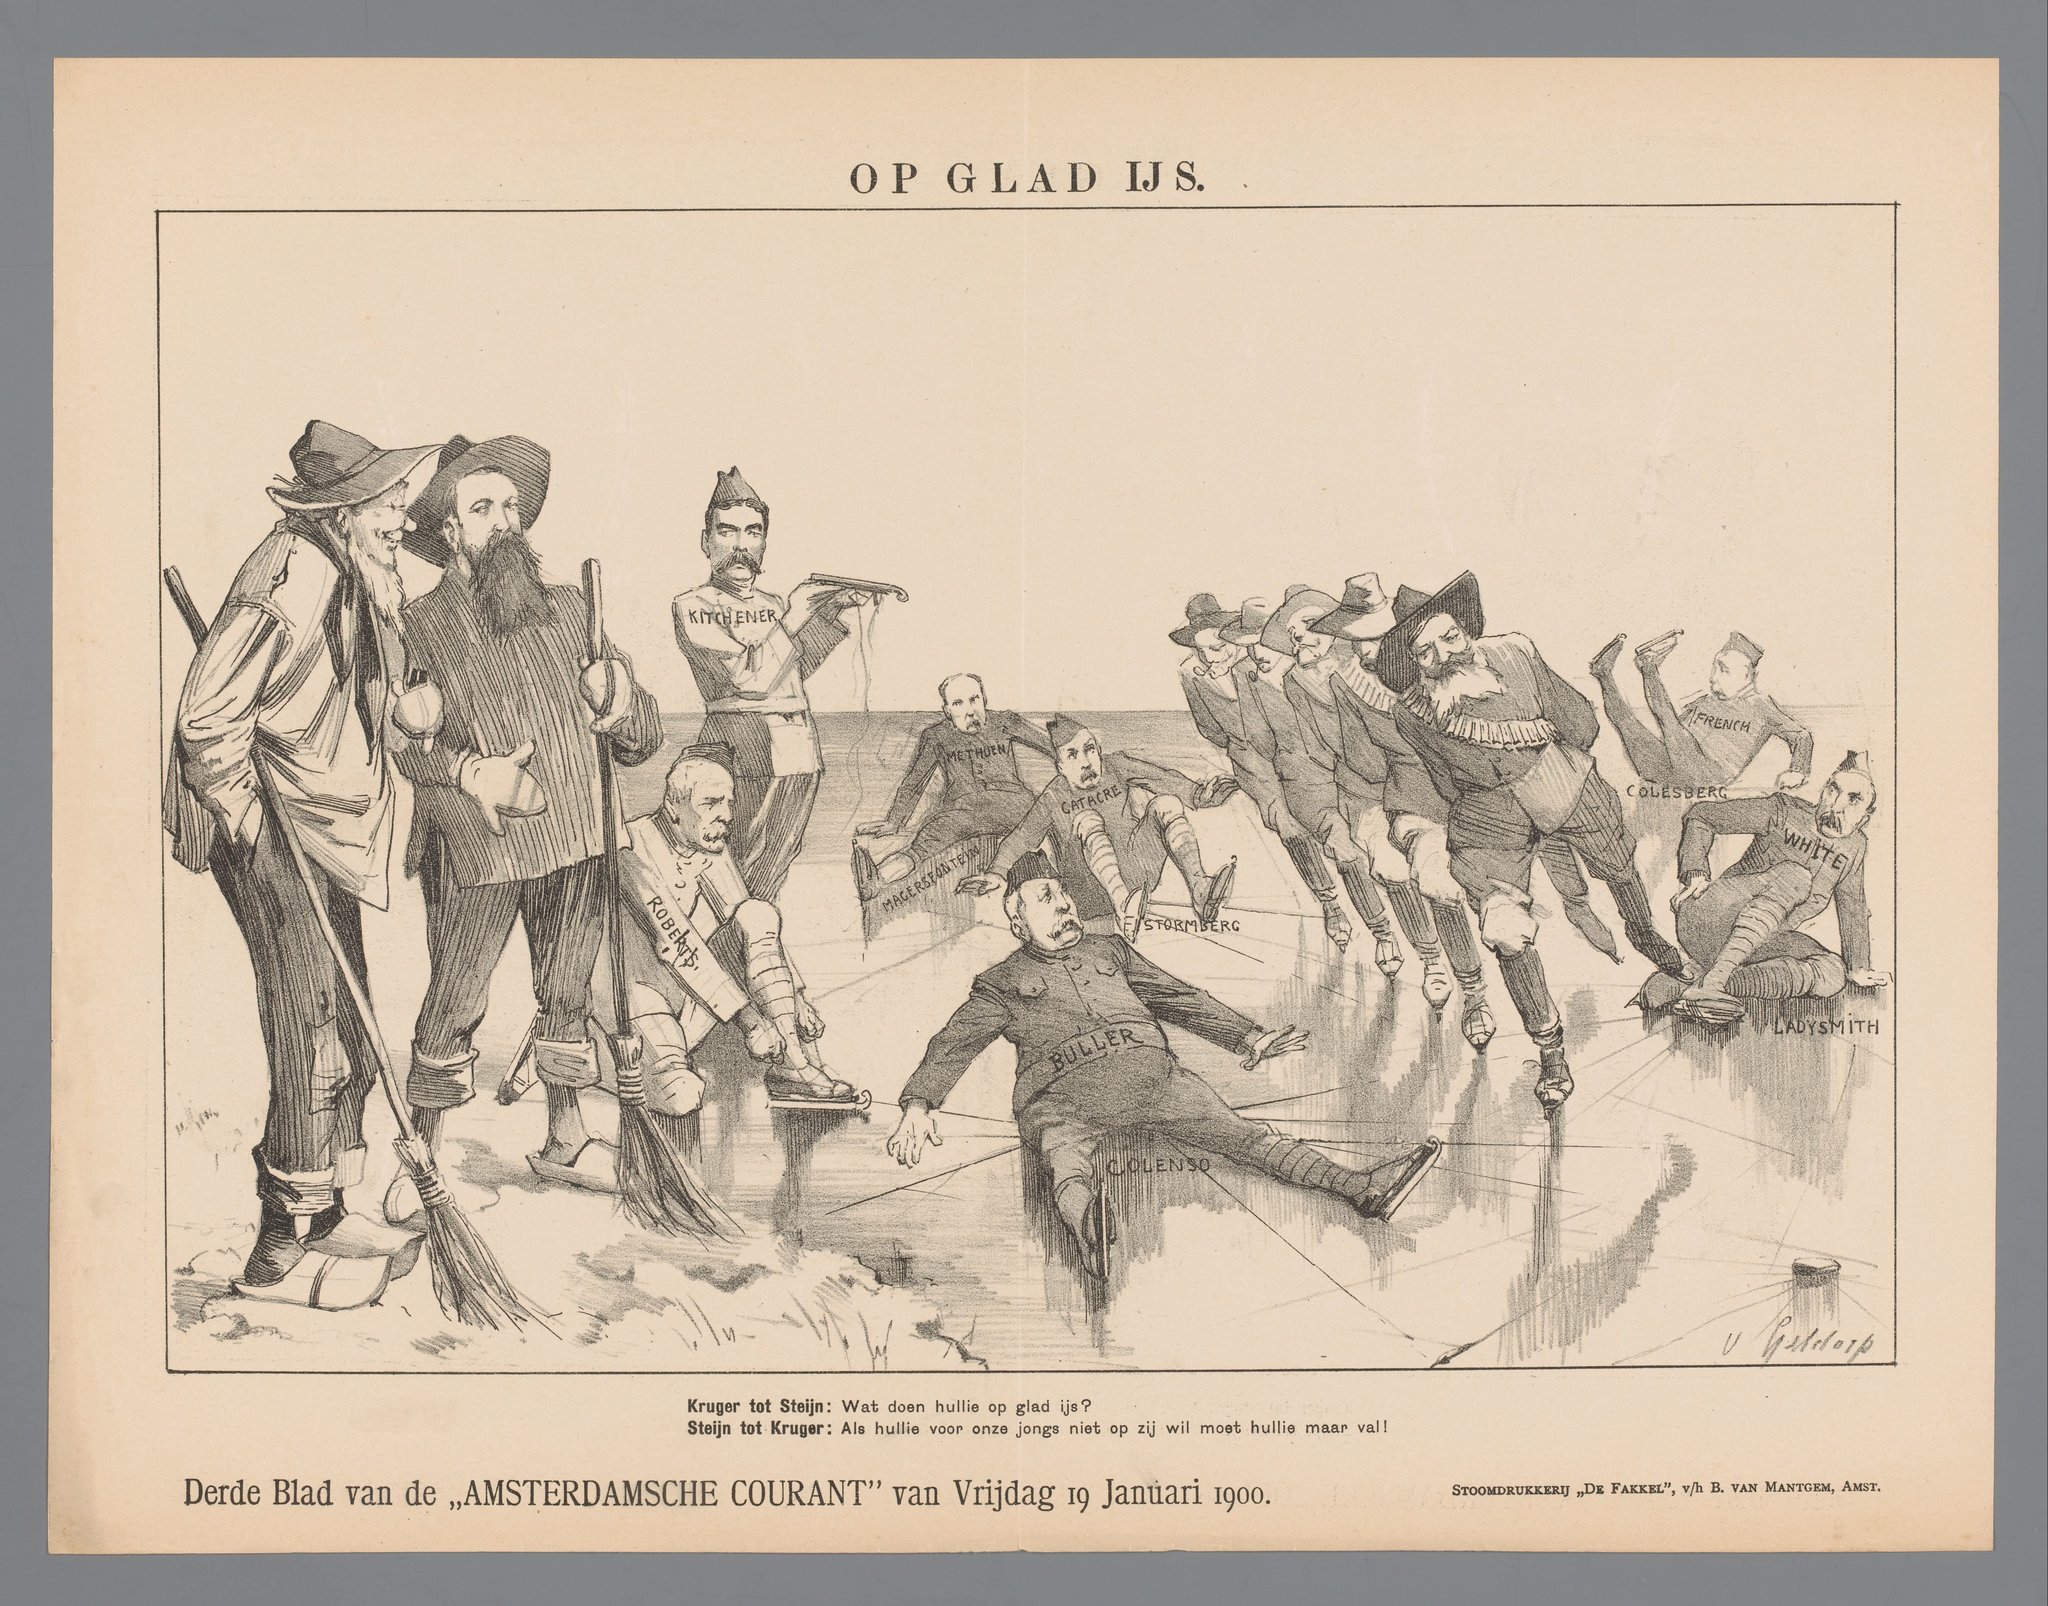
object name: cartoon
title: Op glad ijs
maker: petrus van geldorp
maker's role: draughtsman, print maker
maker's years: 1872-1939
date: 1900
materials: paper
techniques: lithograph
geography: amsterdam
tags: politician, horatio herbert kitchener, historical persons, skates (winter sports), political caricatures and satires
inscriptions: date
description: Prent uit het bijvoegsel van: De Amsterdamsche Courant, 19 januari 1900.